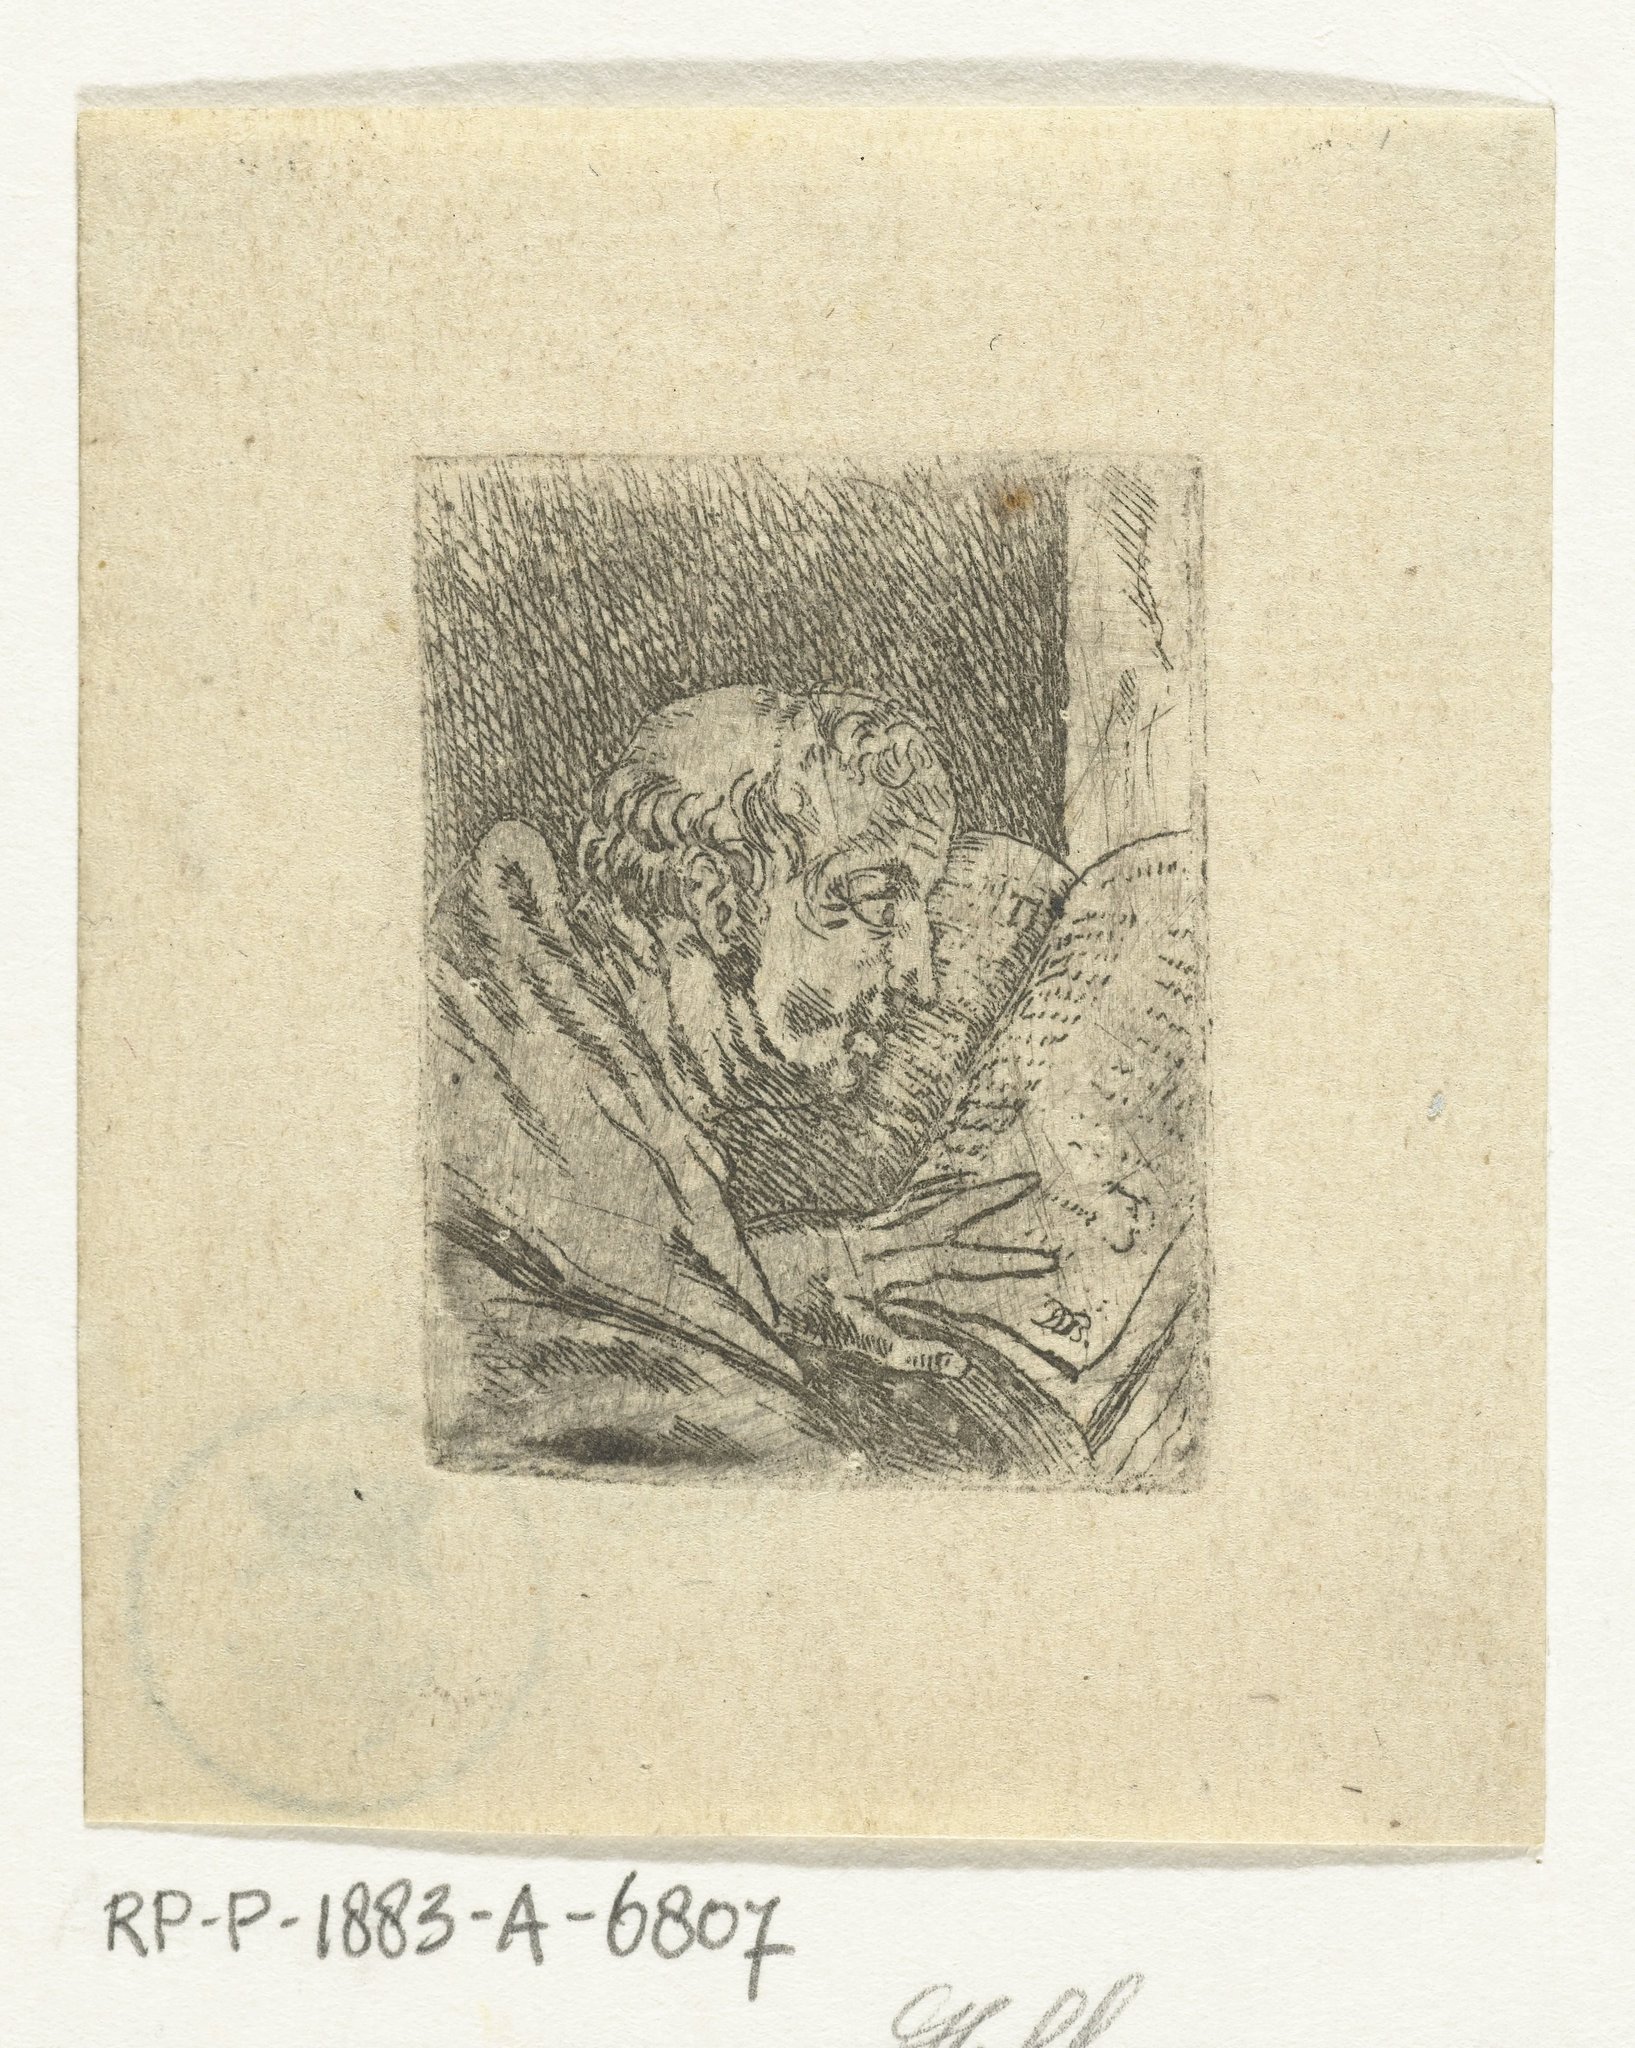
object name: print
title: Monnik leest bijbel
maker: dirck de bray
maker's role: draughtsman, painter, print maker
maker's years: 1625-1694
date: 1645-1694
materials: paper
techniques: etching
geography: netherlands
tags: monk(s), friar(s)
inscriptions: collector's mark: Lugt 514, collector's mark: Lugt 2227